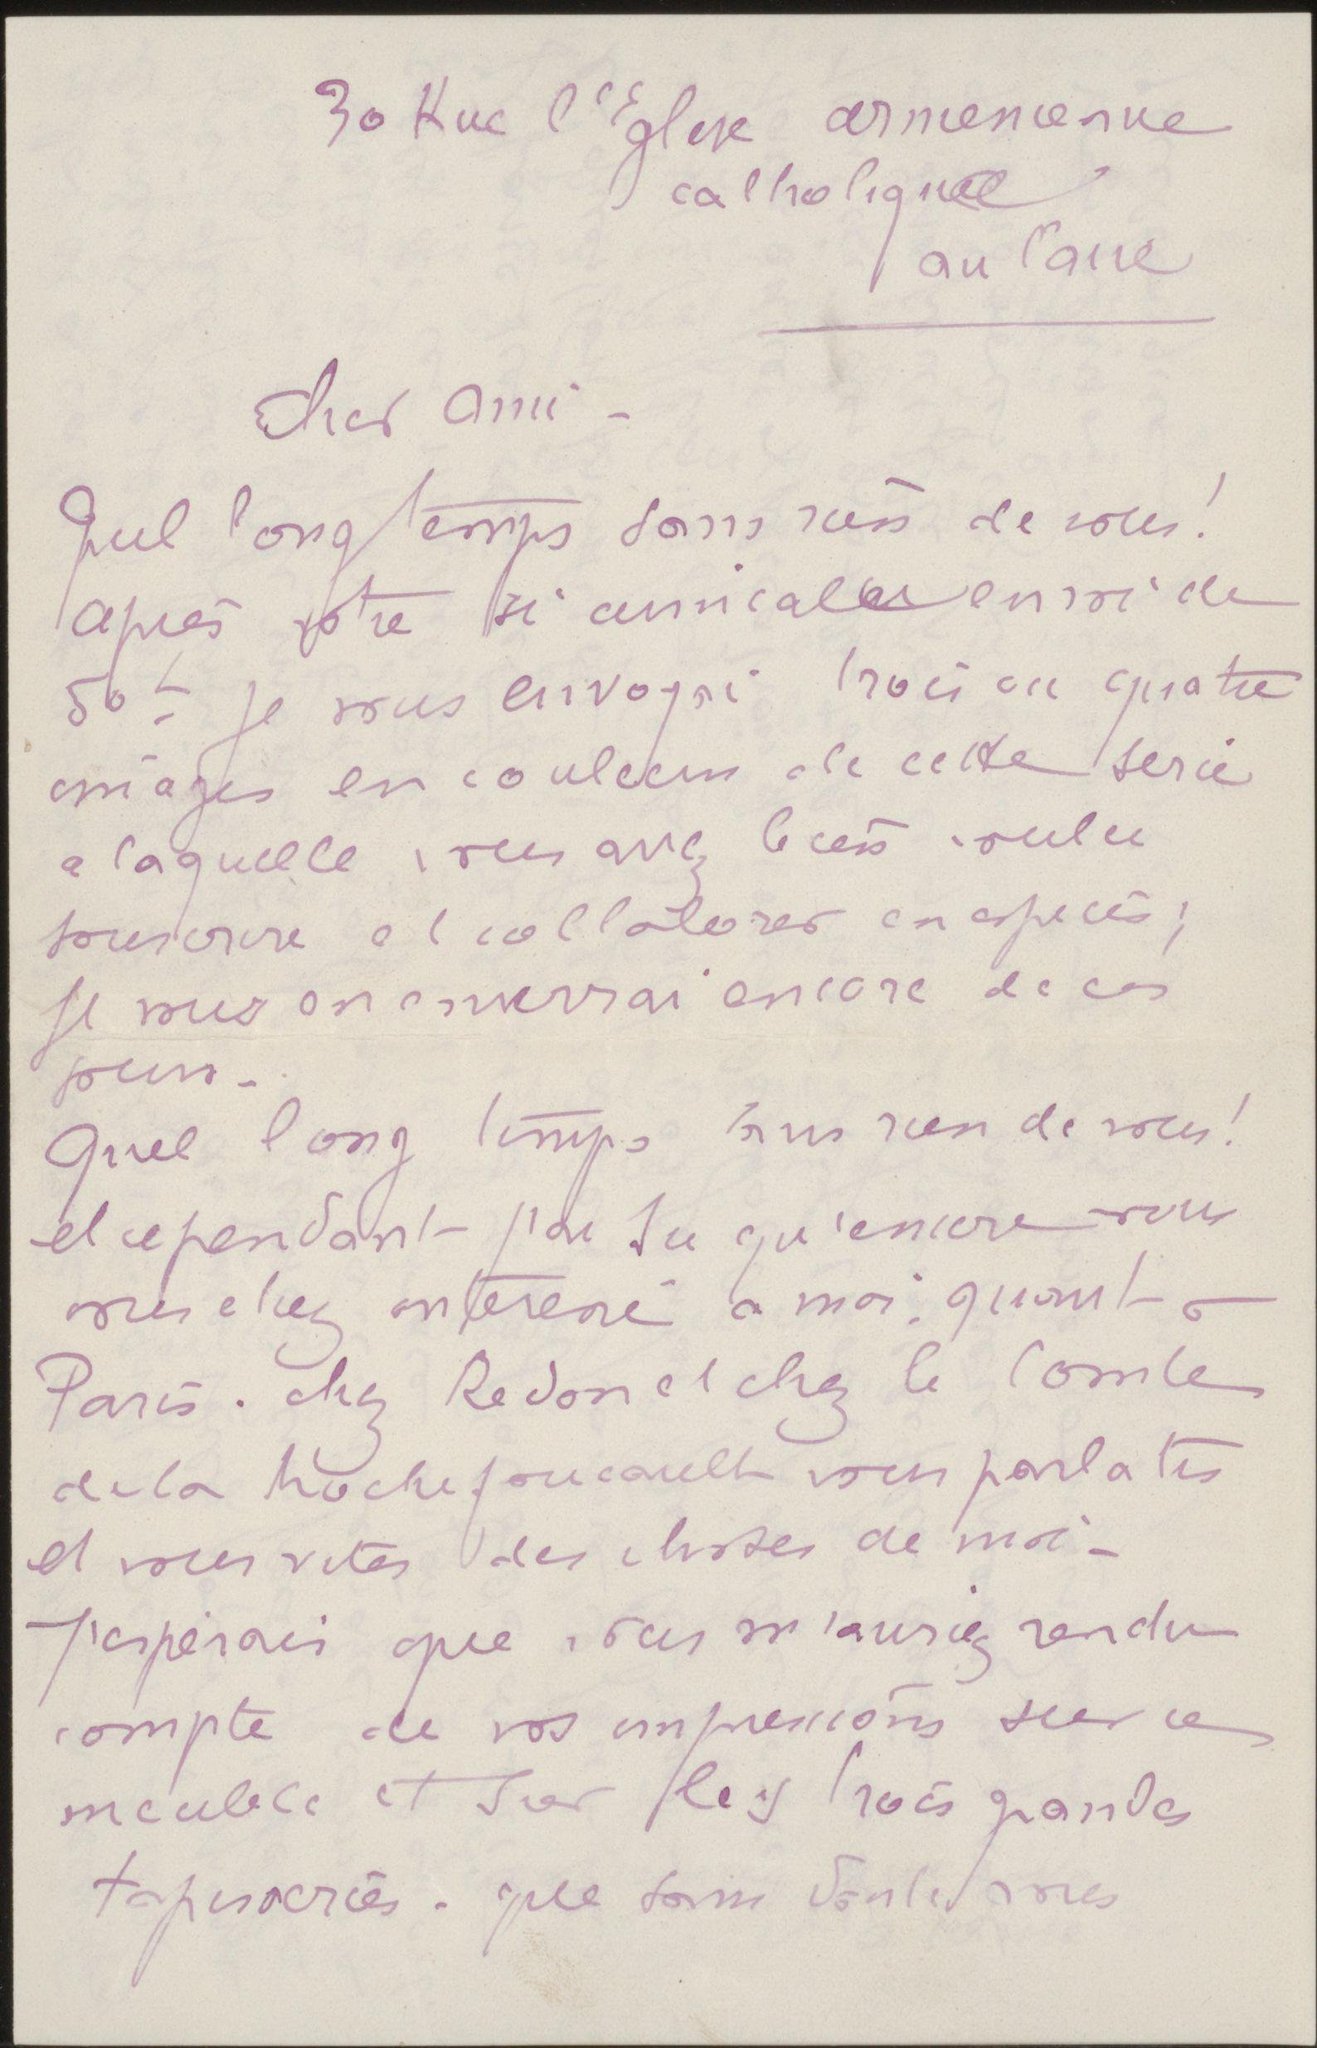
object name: letter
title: Brief aan Andries Bonger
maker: émile bernard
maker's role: print maker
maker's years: 1868-1941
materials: ink, paper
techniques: pen, writing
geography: cairo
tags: draughtsman, odilon redon, amsterdam, andries bonger, applied arts, arts and crafts; industrial design, family life, diseases, paris, spain